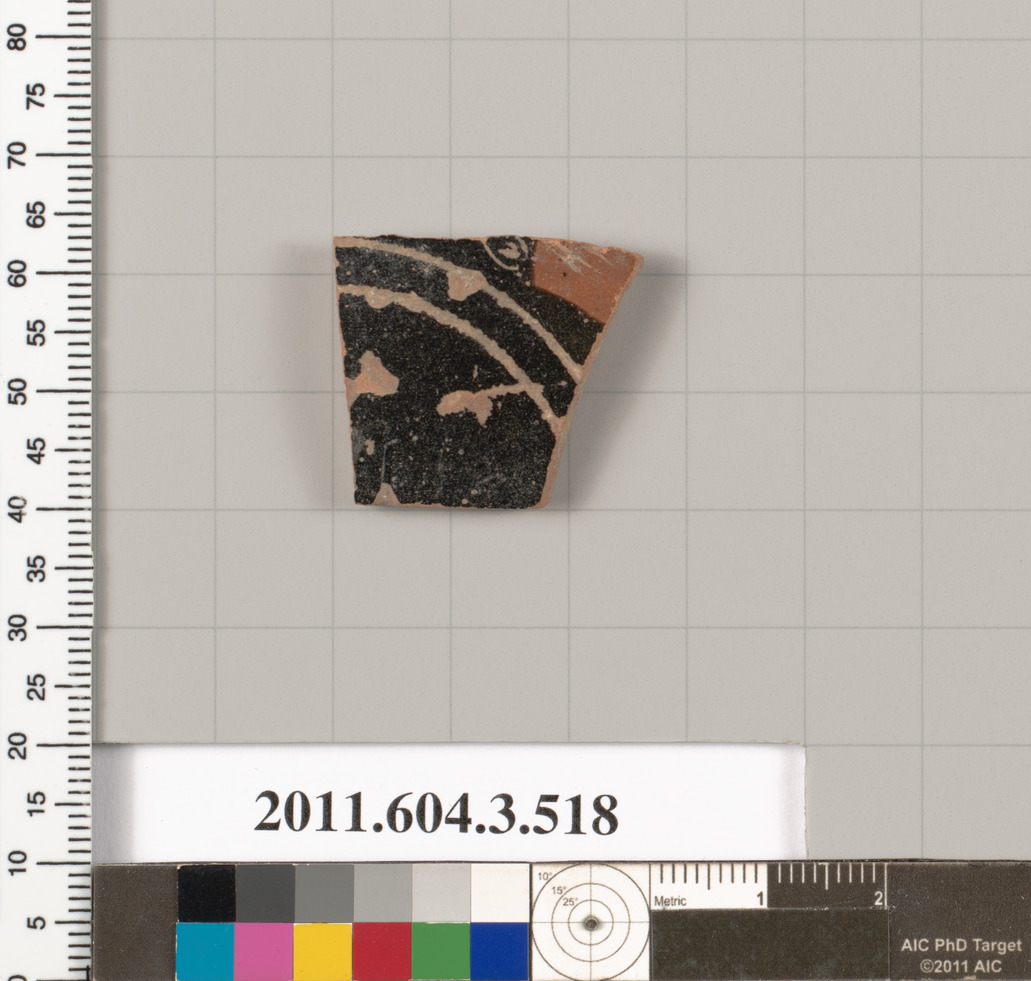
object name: column krater fragment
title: Terracotta fragment of a column-krater (bowl for mixing wine and water)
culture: greek, attic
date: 500-468 BCE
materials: terracotta